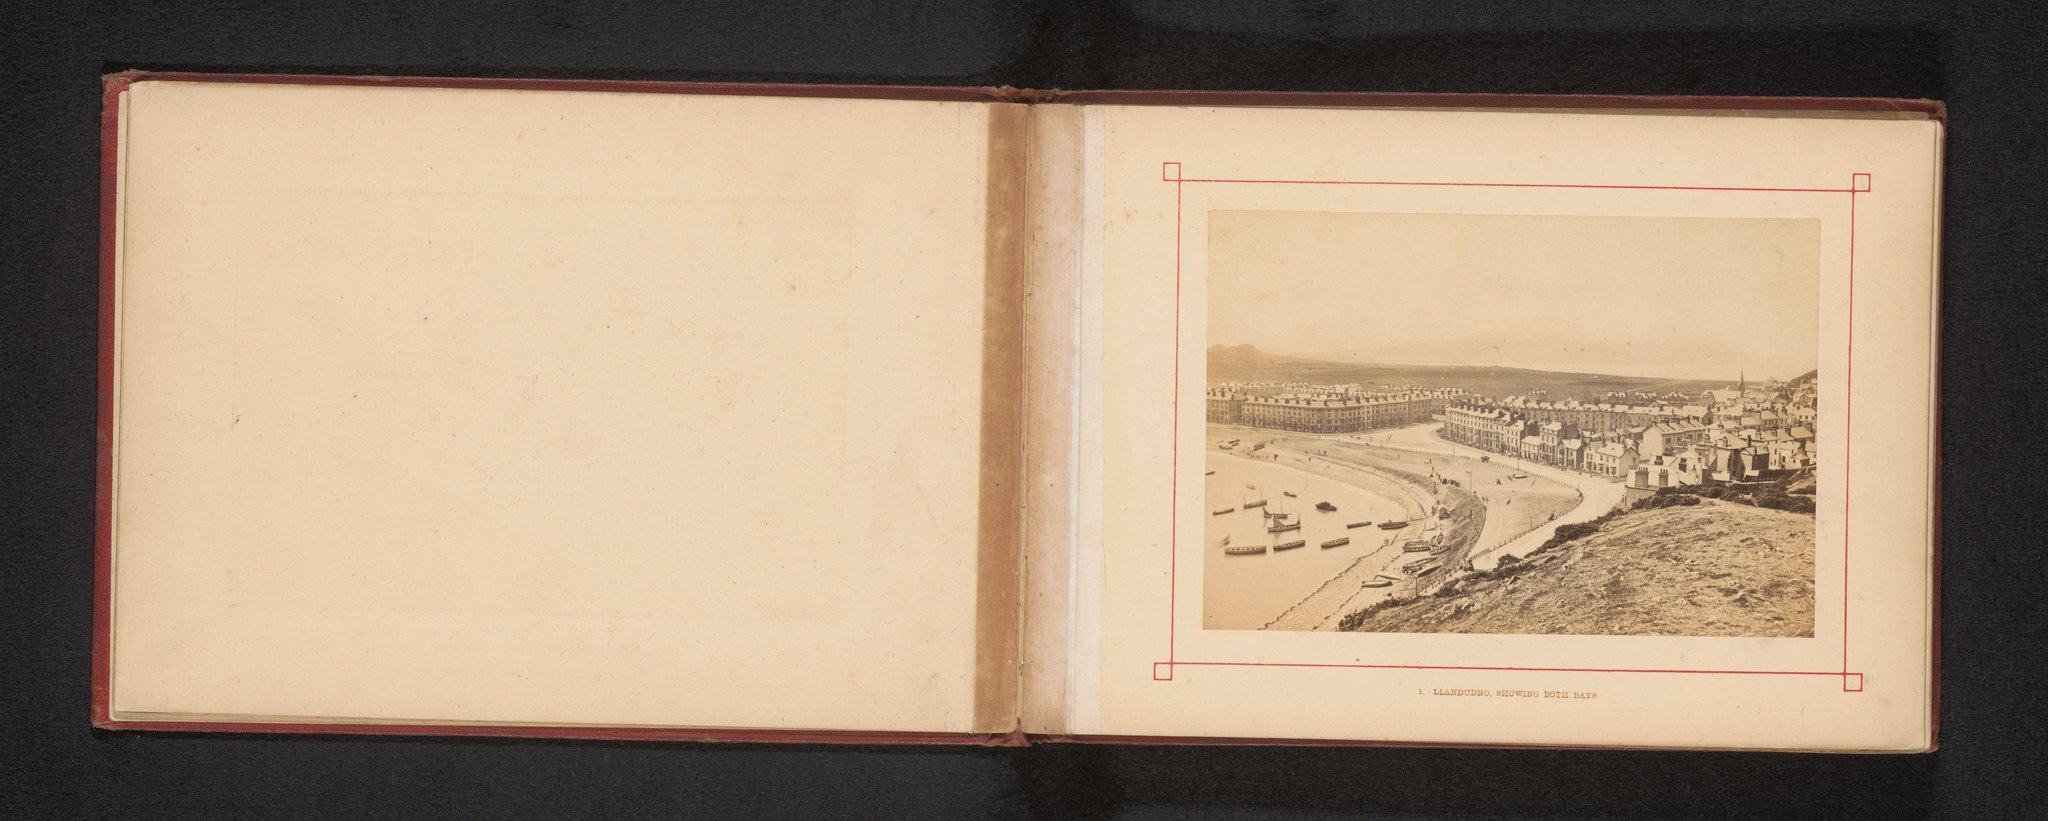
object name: page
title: Gezicht op de kust van LLandudno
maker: francis bedford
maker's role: print maker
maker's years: 1815-1894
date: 1865-1870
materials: photographic support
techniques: albumen print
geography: llandudno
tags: landscapes with waters, waterscapes, seascapes (in the temperate zone), coast